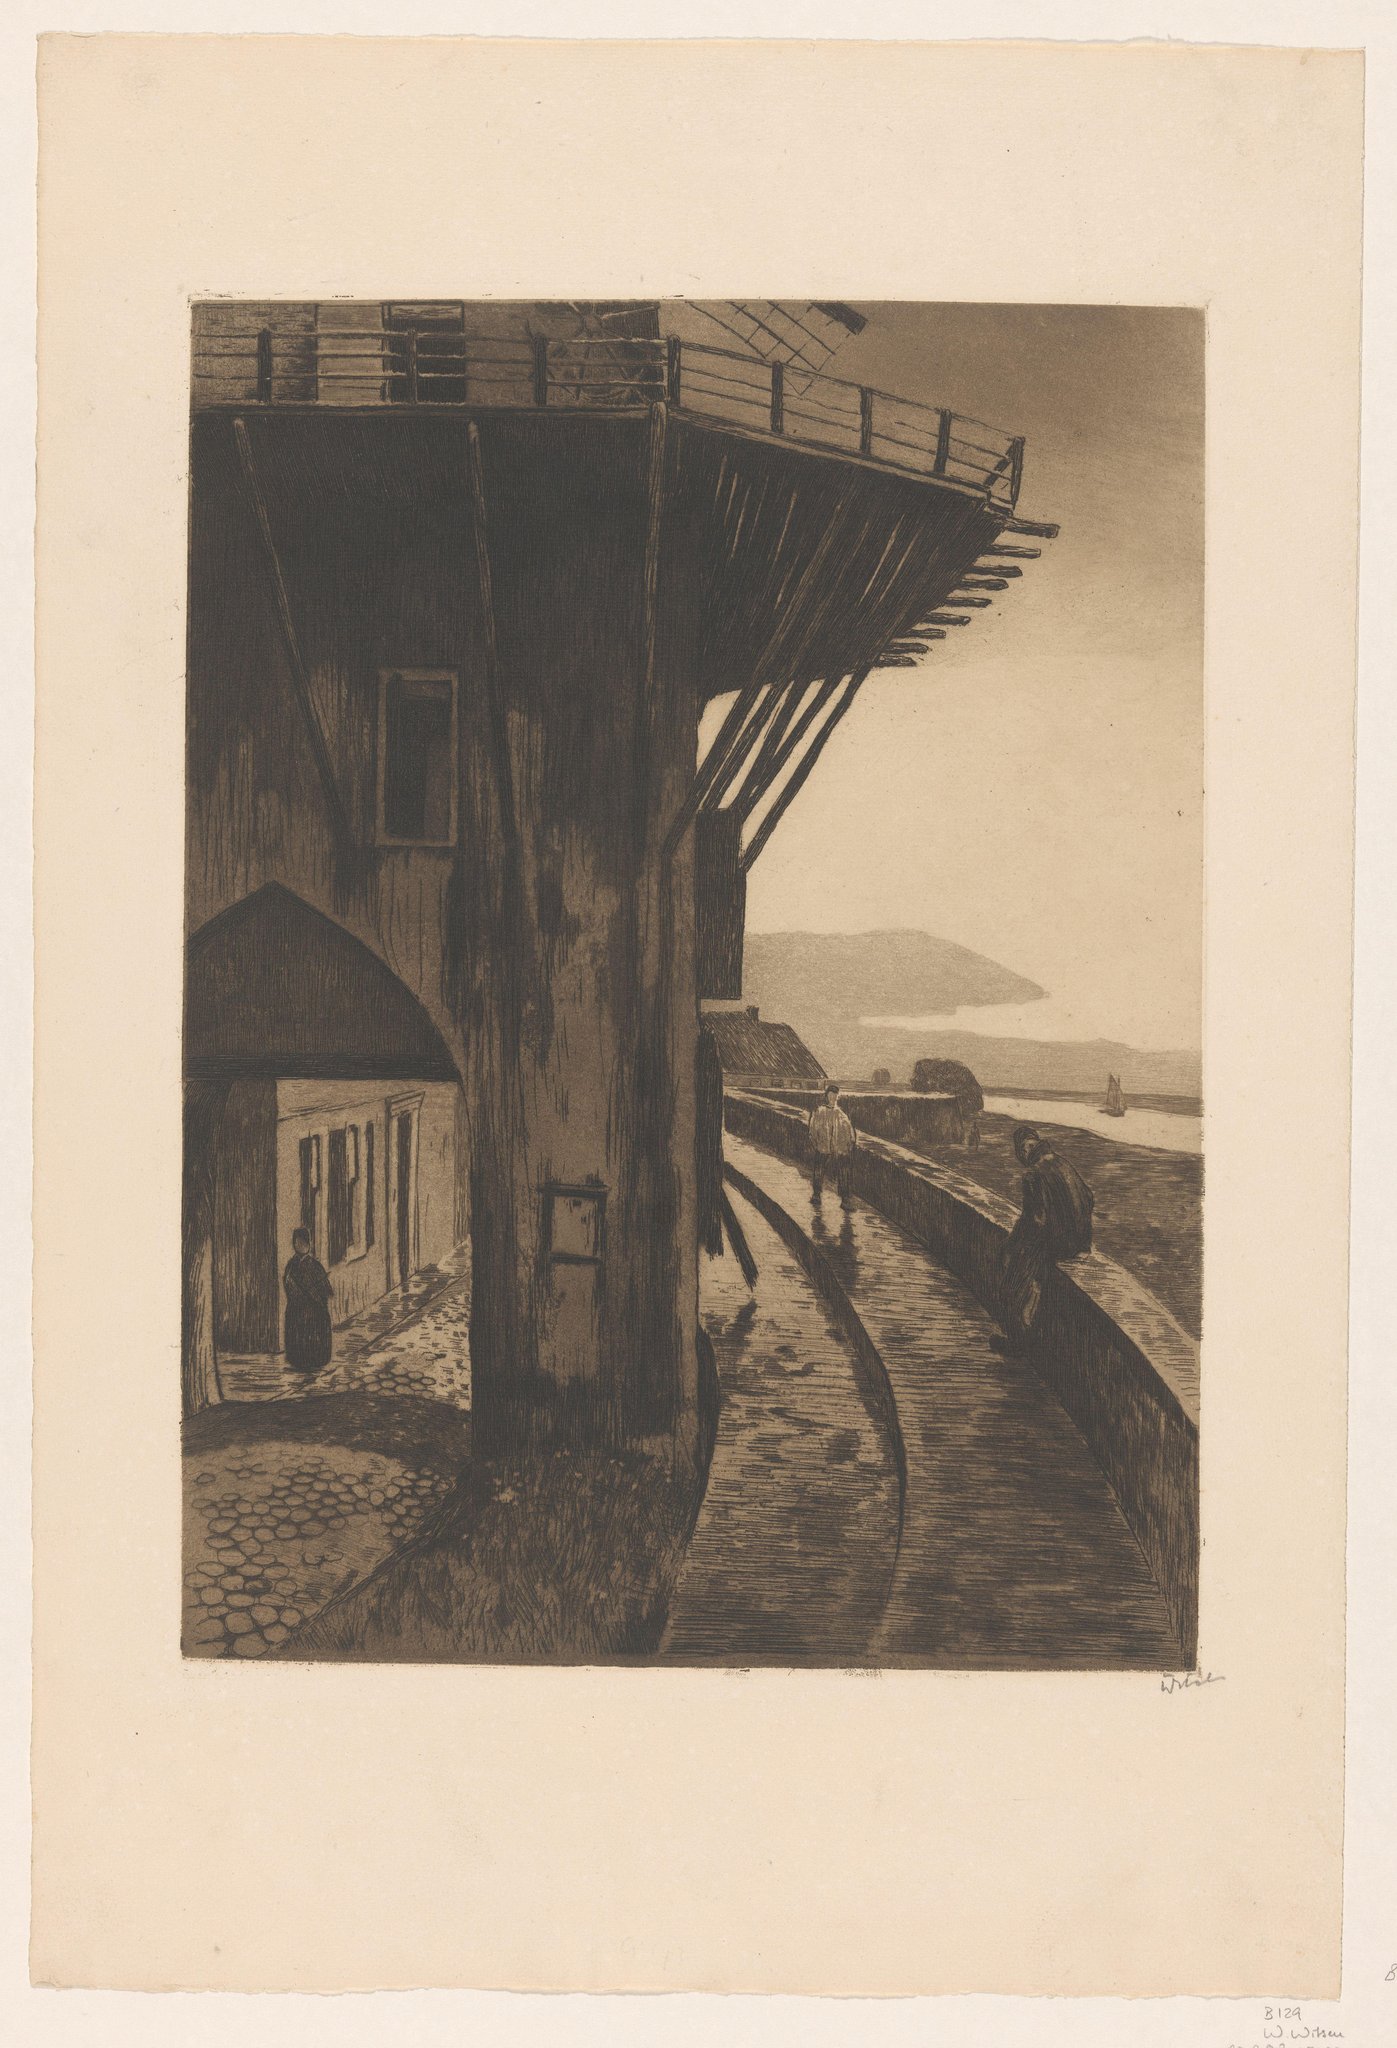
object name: print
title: Gezicht op de Molenpoort in Wijk bij Duurstede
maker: willem witsen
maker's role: draughtsman, painter, print maker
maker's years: 1860-1923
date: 1908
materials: paper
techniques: aquatint, etching, intaglio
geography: the hague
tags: city-view, and landscape with man-made constructions, village street, windmill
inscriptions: collector's mark: Lugt 2228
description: De Molen Rijn en Lek in Wijk bij Duurstede.